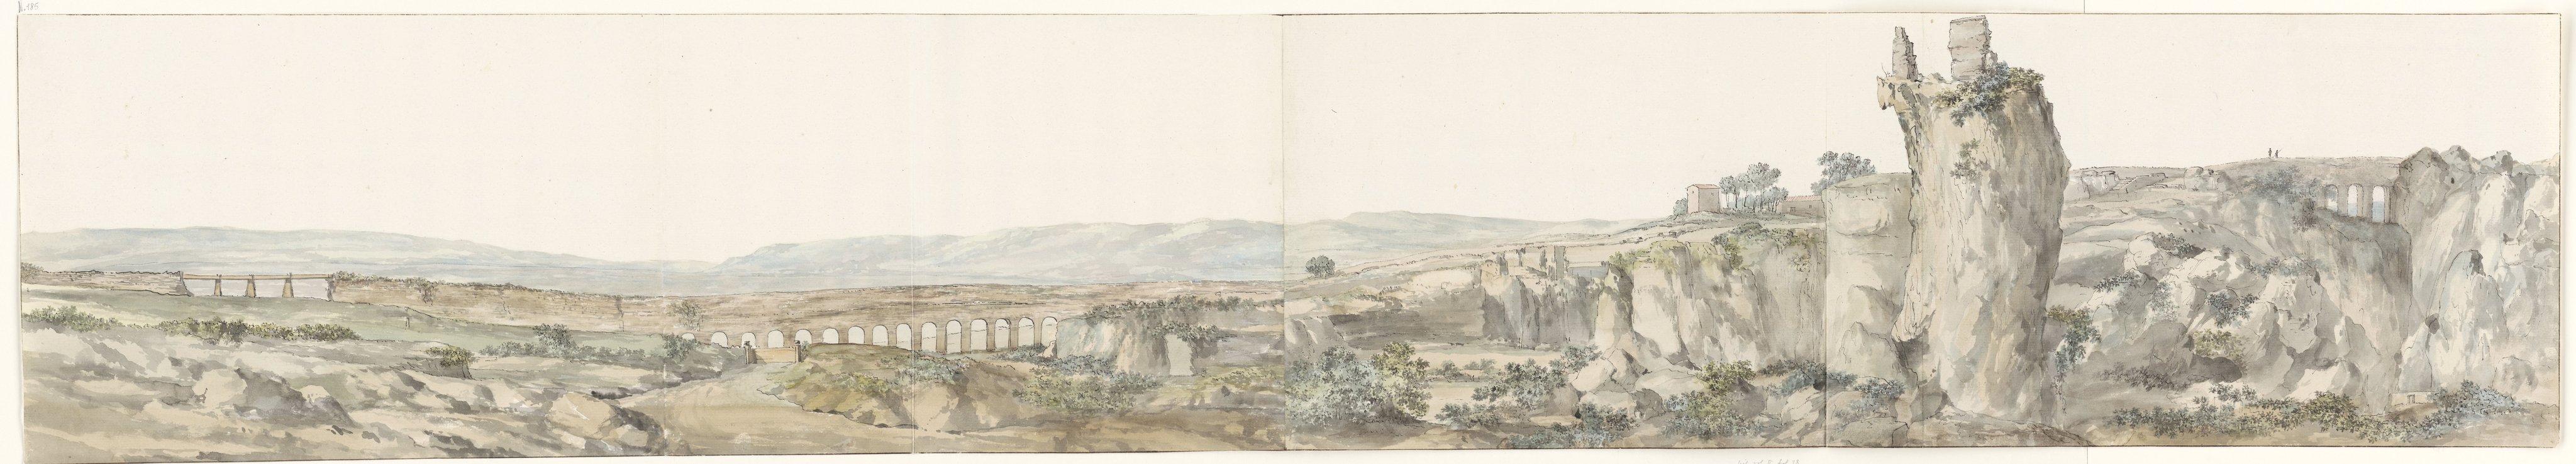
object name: drawing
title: Partie des Latomies de Syracuse servant anciennement de prison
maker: louis ducros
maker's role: draughtsman, print maker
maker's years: 1748-1810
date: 1778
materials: chalk, paper, watercolor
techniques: brush, pen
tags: city-view, and landscape with man-made constructions, cave, grotto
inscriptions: inscription: ‘No 185 Partie des Latomies de Syracuse servant anciennement de prison’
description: Tekening uit het album 'Voyage en Italie, en Sicile et à Malte', 1778.